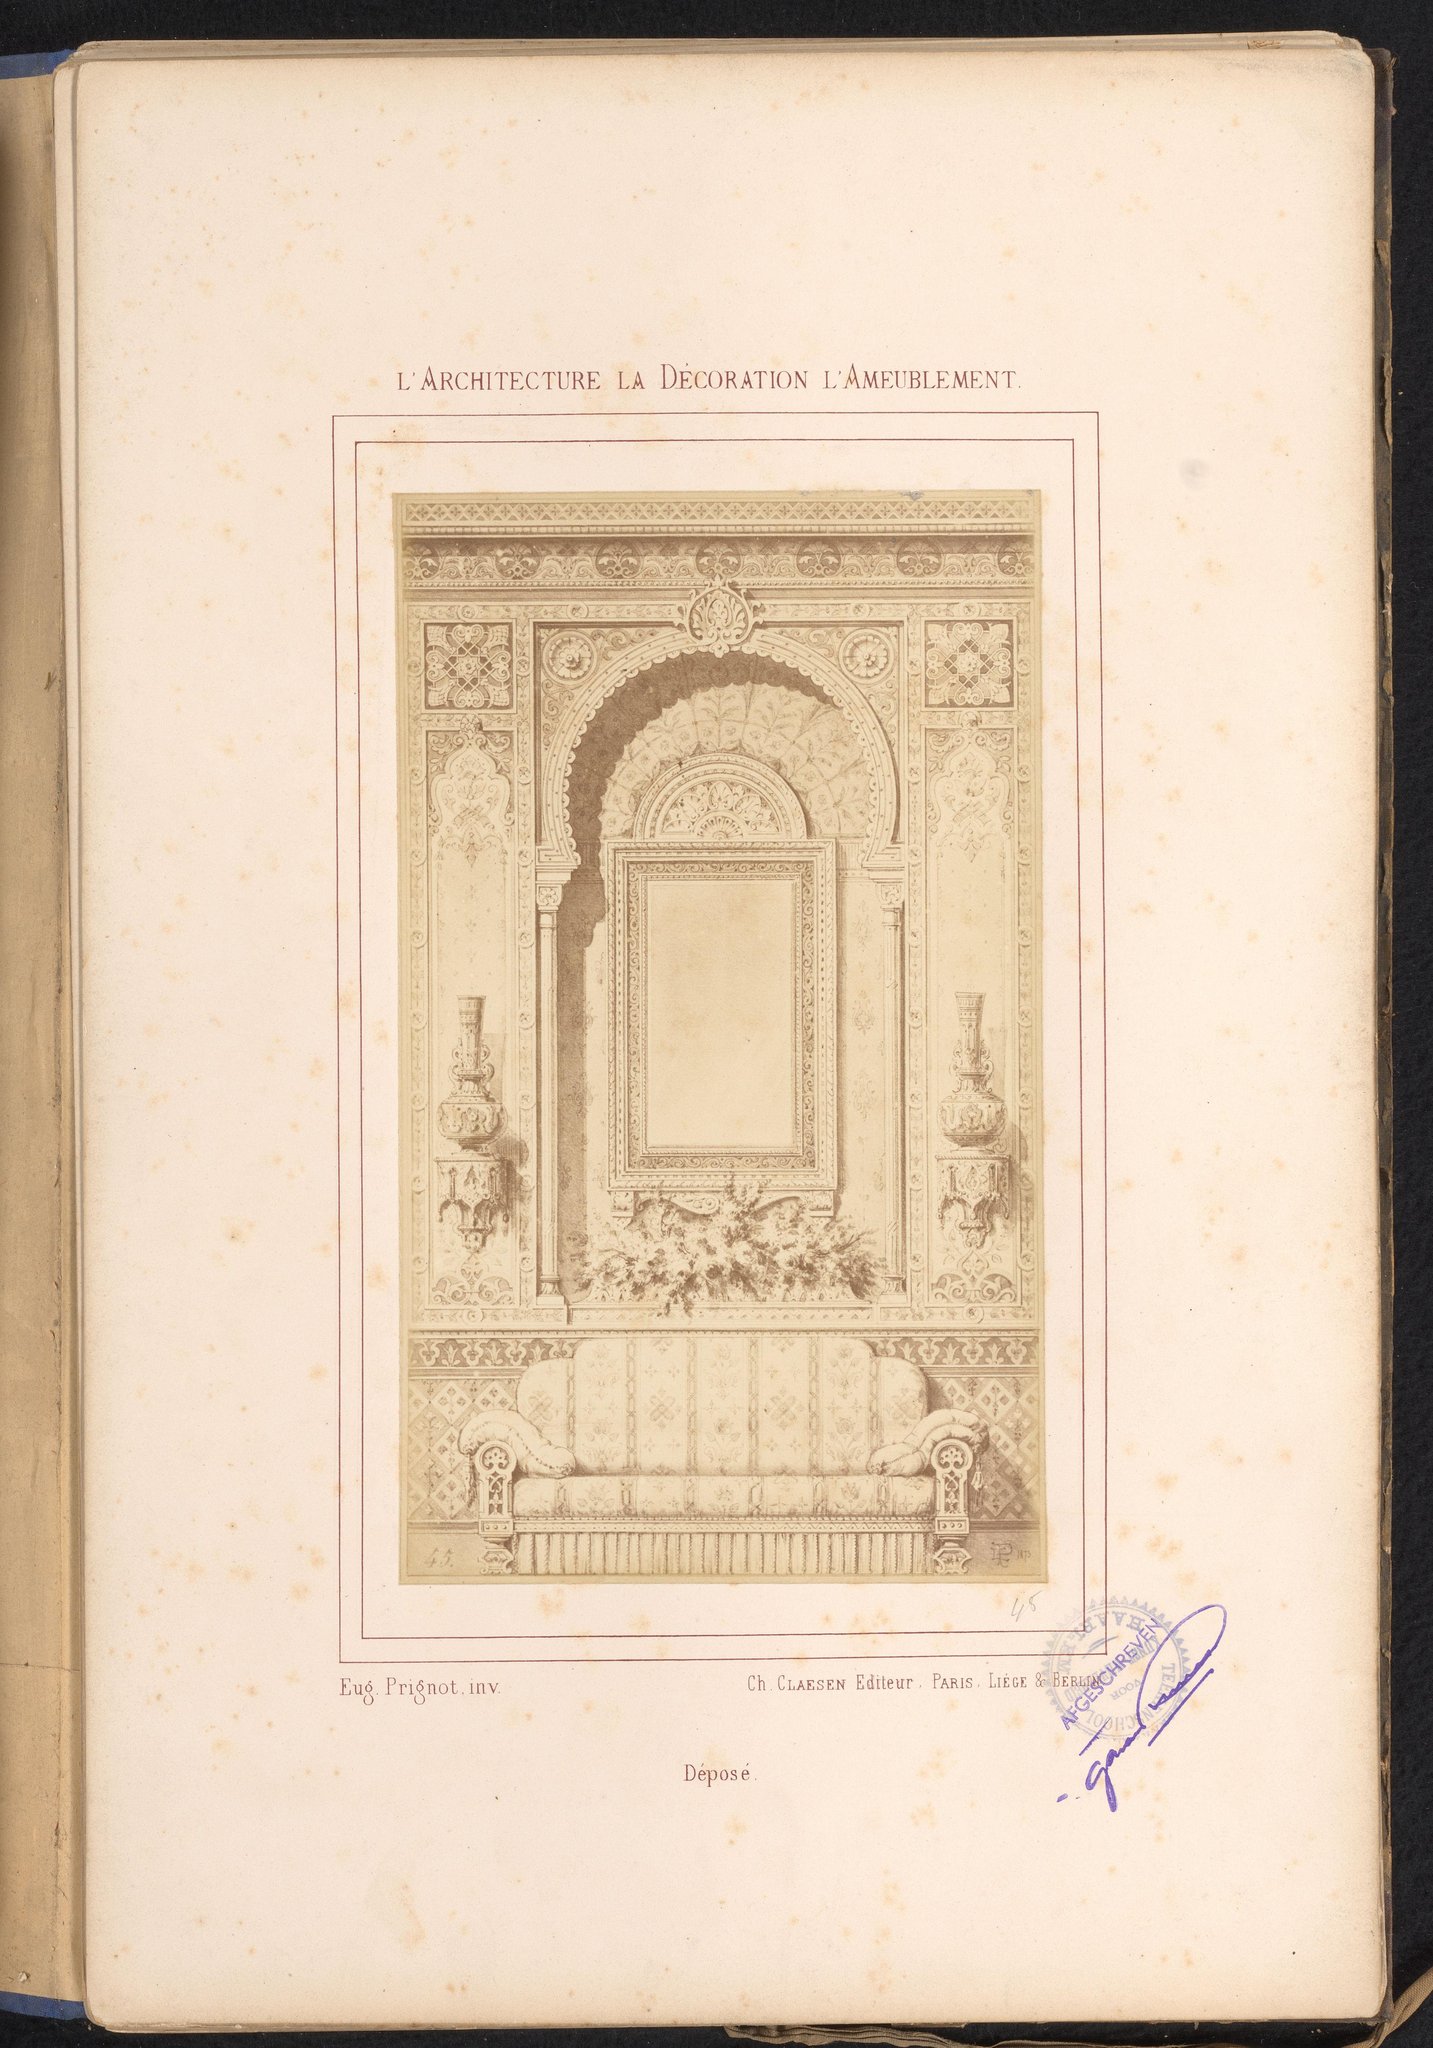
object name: photograph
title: Fotoreproductie van een ontwerp voor een wandindeling met een sofa en een spiegel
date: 1873-1880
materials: cardboard, paper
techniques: albumen print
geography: liège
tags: mirror, container of ceramics: jar, jug, pot, vase, couch, sofa, settee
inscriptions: inscription: ‘Eug. Prignot. inv.’, stamp: ‘AFGESCHREVEN/ [...]’, inscription: ‘Déposé’, stamp: ‘TEEKENSCHOOL/ VOOR/ KUNST-NIJVERHEID/ HAARLEM’, number: ‘45’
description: Deze foto maakt deel uit van een omslag met 61 foto's op 61 bladen.